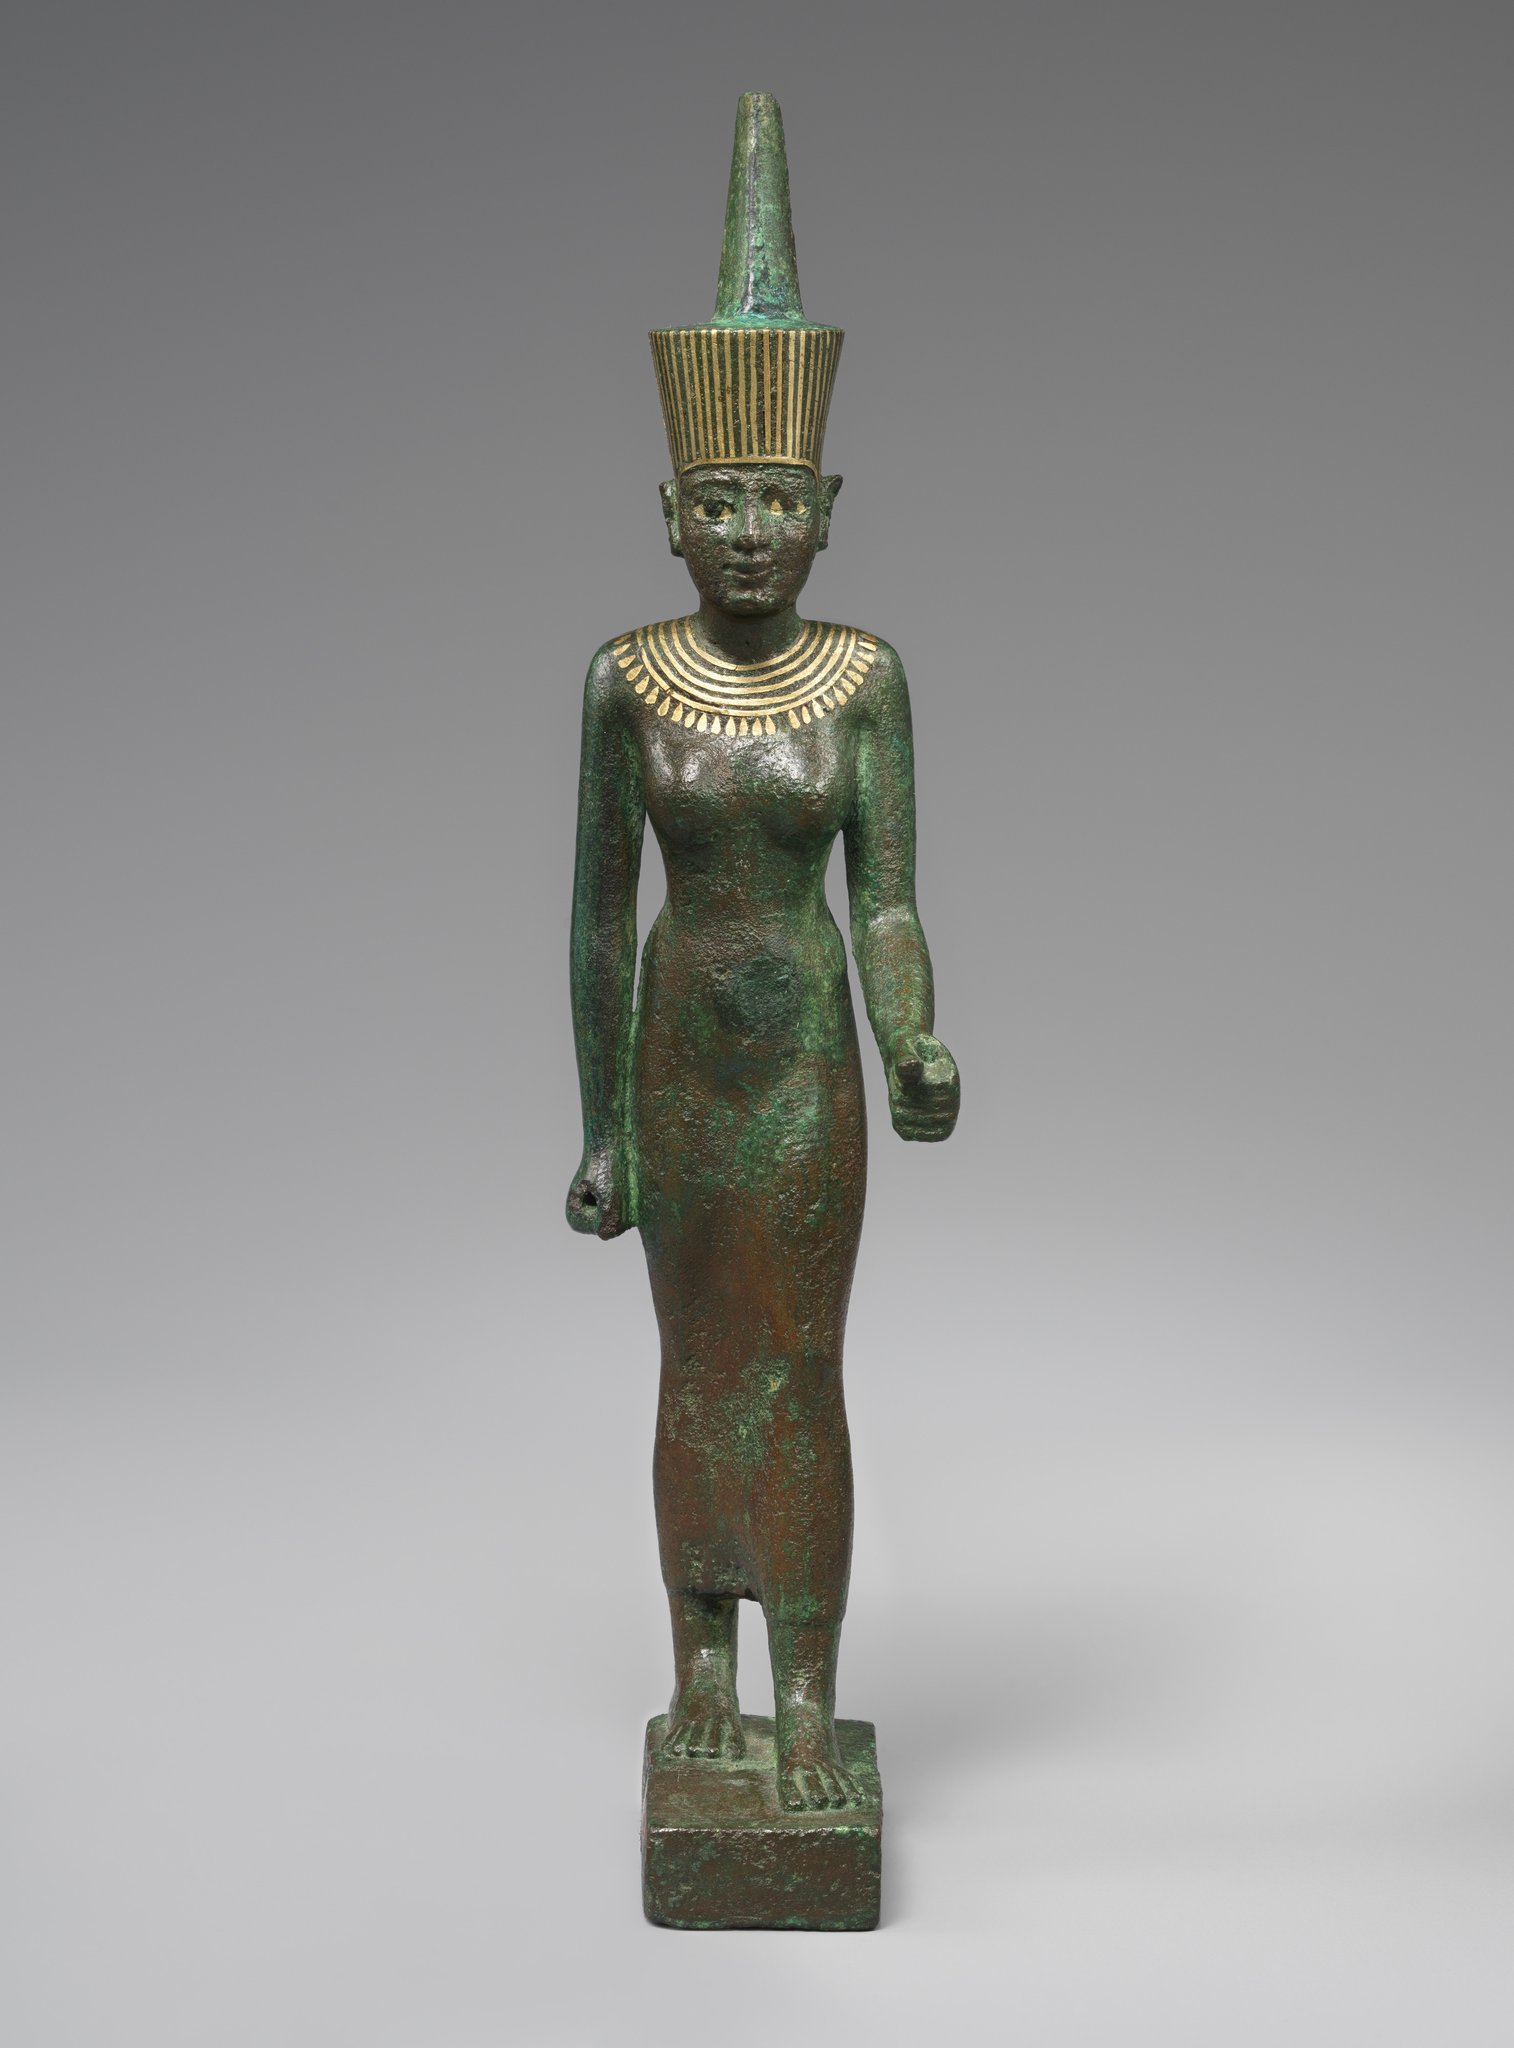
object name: statuette, neit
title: Statuette of Neit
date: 664-332 BCE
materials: metal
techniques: inlay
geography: egypt